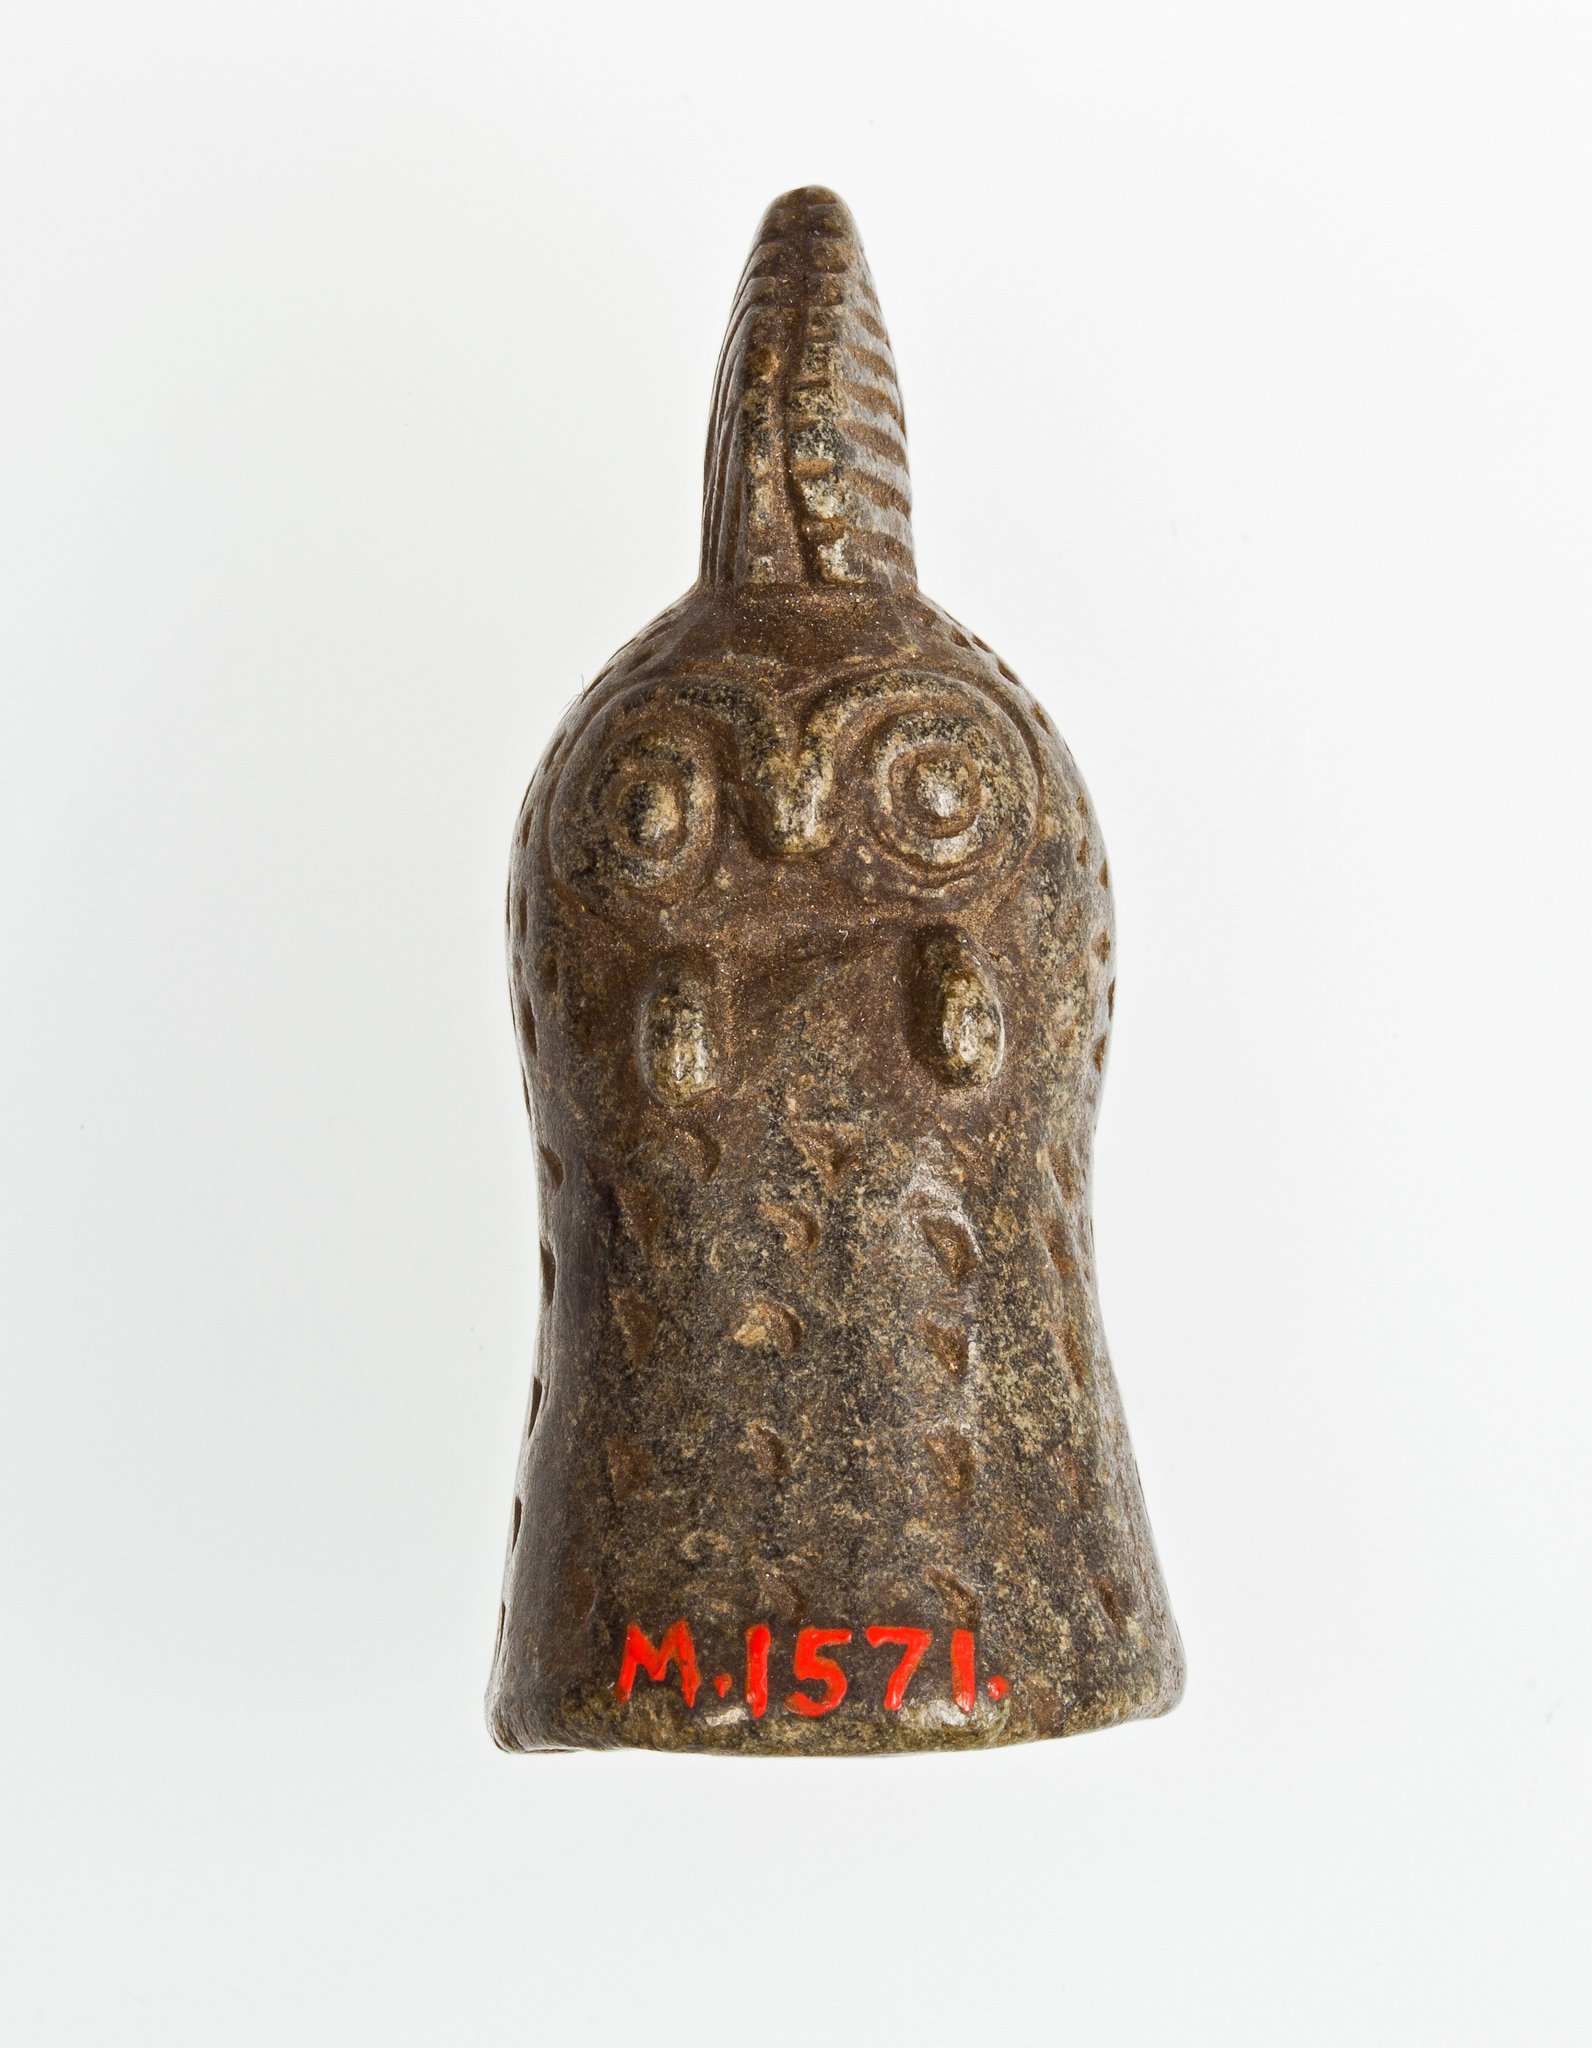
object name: game piece, bird head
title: Game piece(?) in the shape of a bird's head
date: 304-30 BCE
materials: limestone, pigment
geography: egypt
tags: birds,games